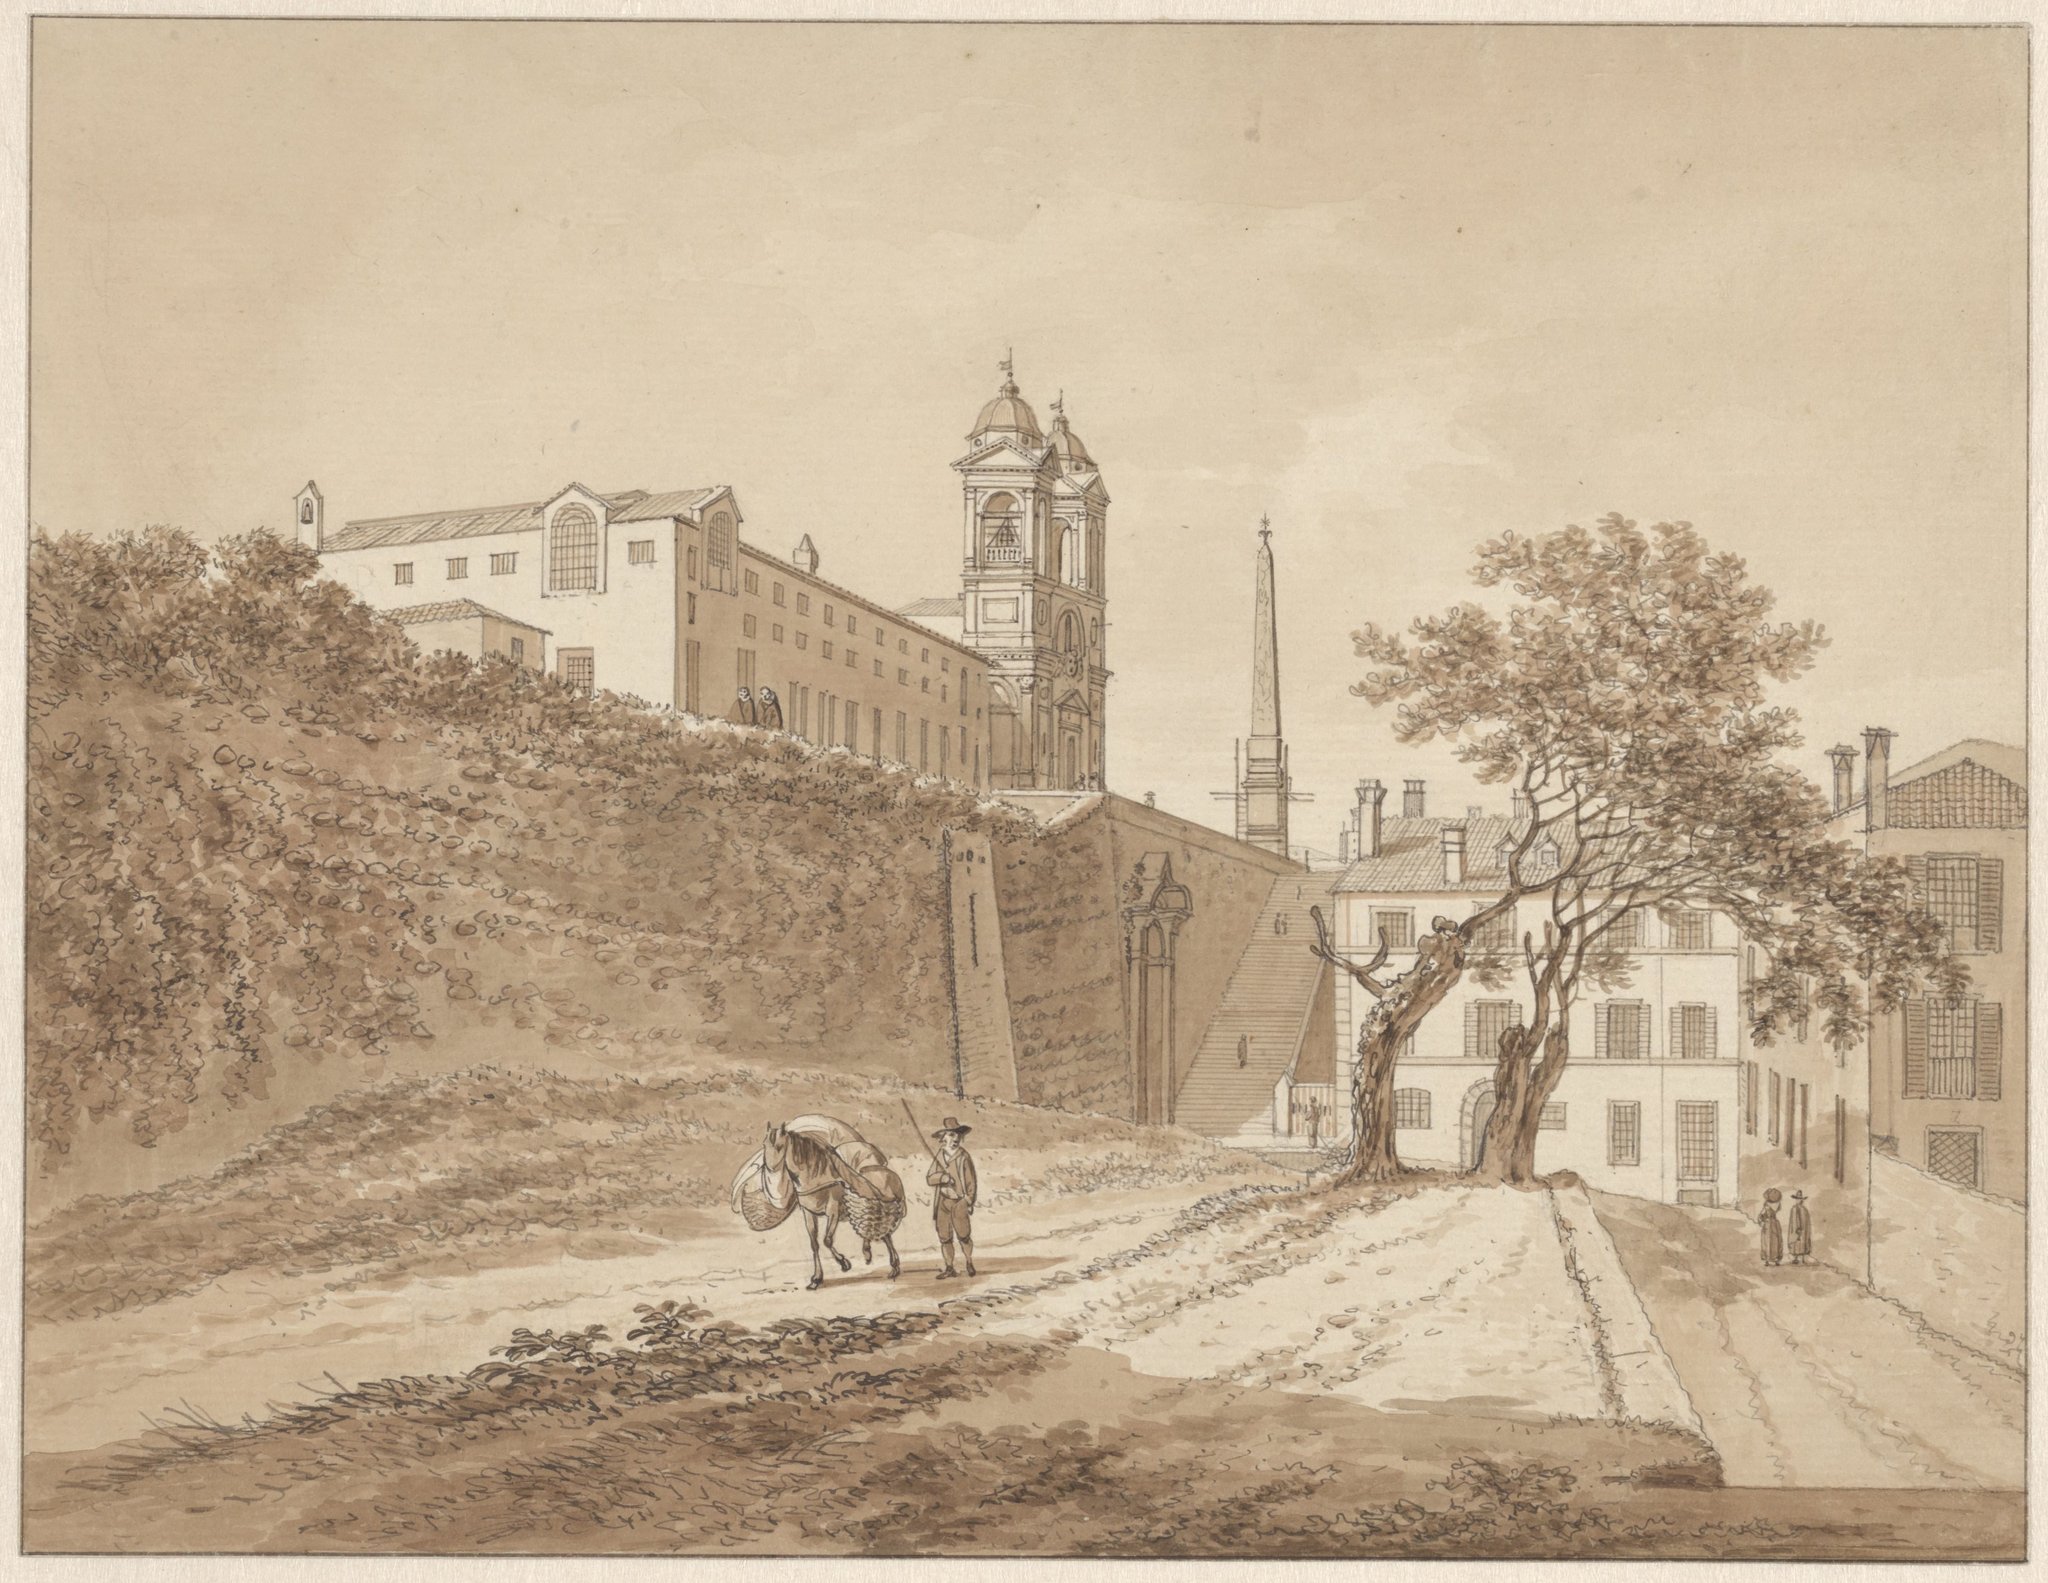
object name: drawing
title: De kerk van de Trinità dei Monti in Rome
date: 1761-1817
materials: chalk, ink, paper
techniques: brush, pen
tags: city-view in general; 'veduta', church (exterior), rome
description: Tekening uit een groep tekeningen van landschappen en stadsgezichten in Italië (Rome, Tivoli, Civita Castellana en Pozzuoli).